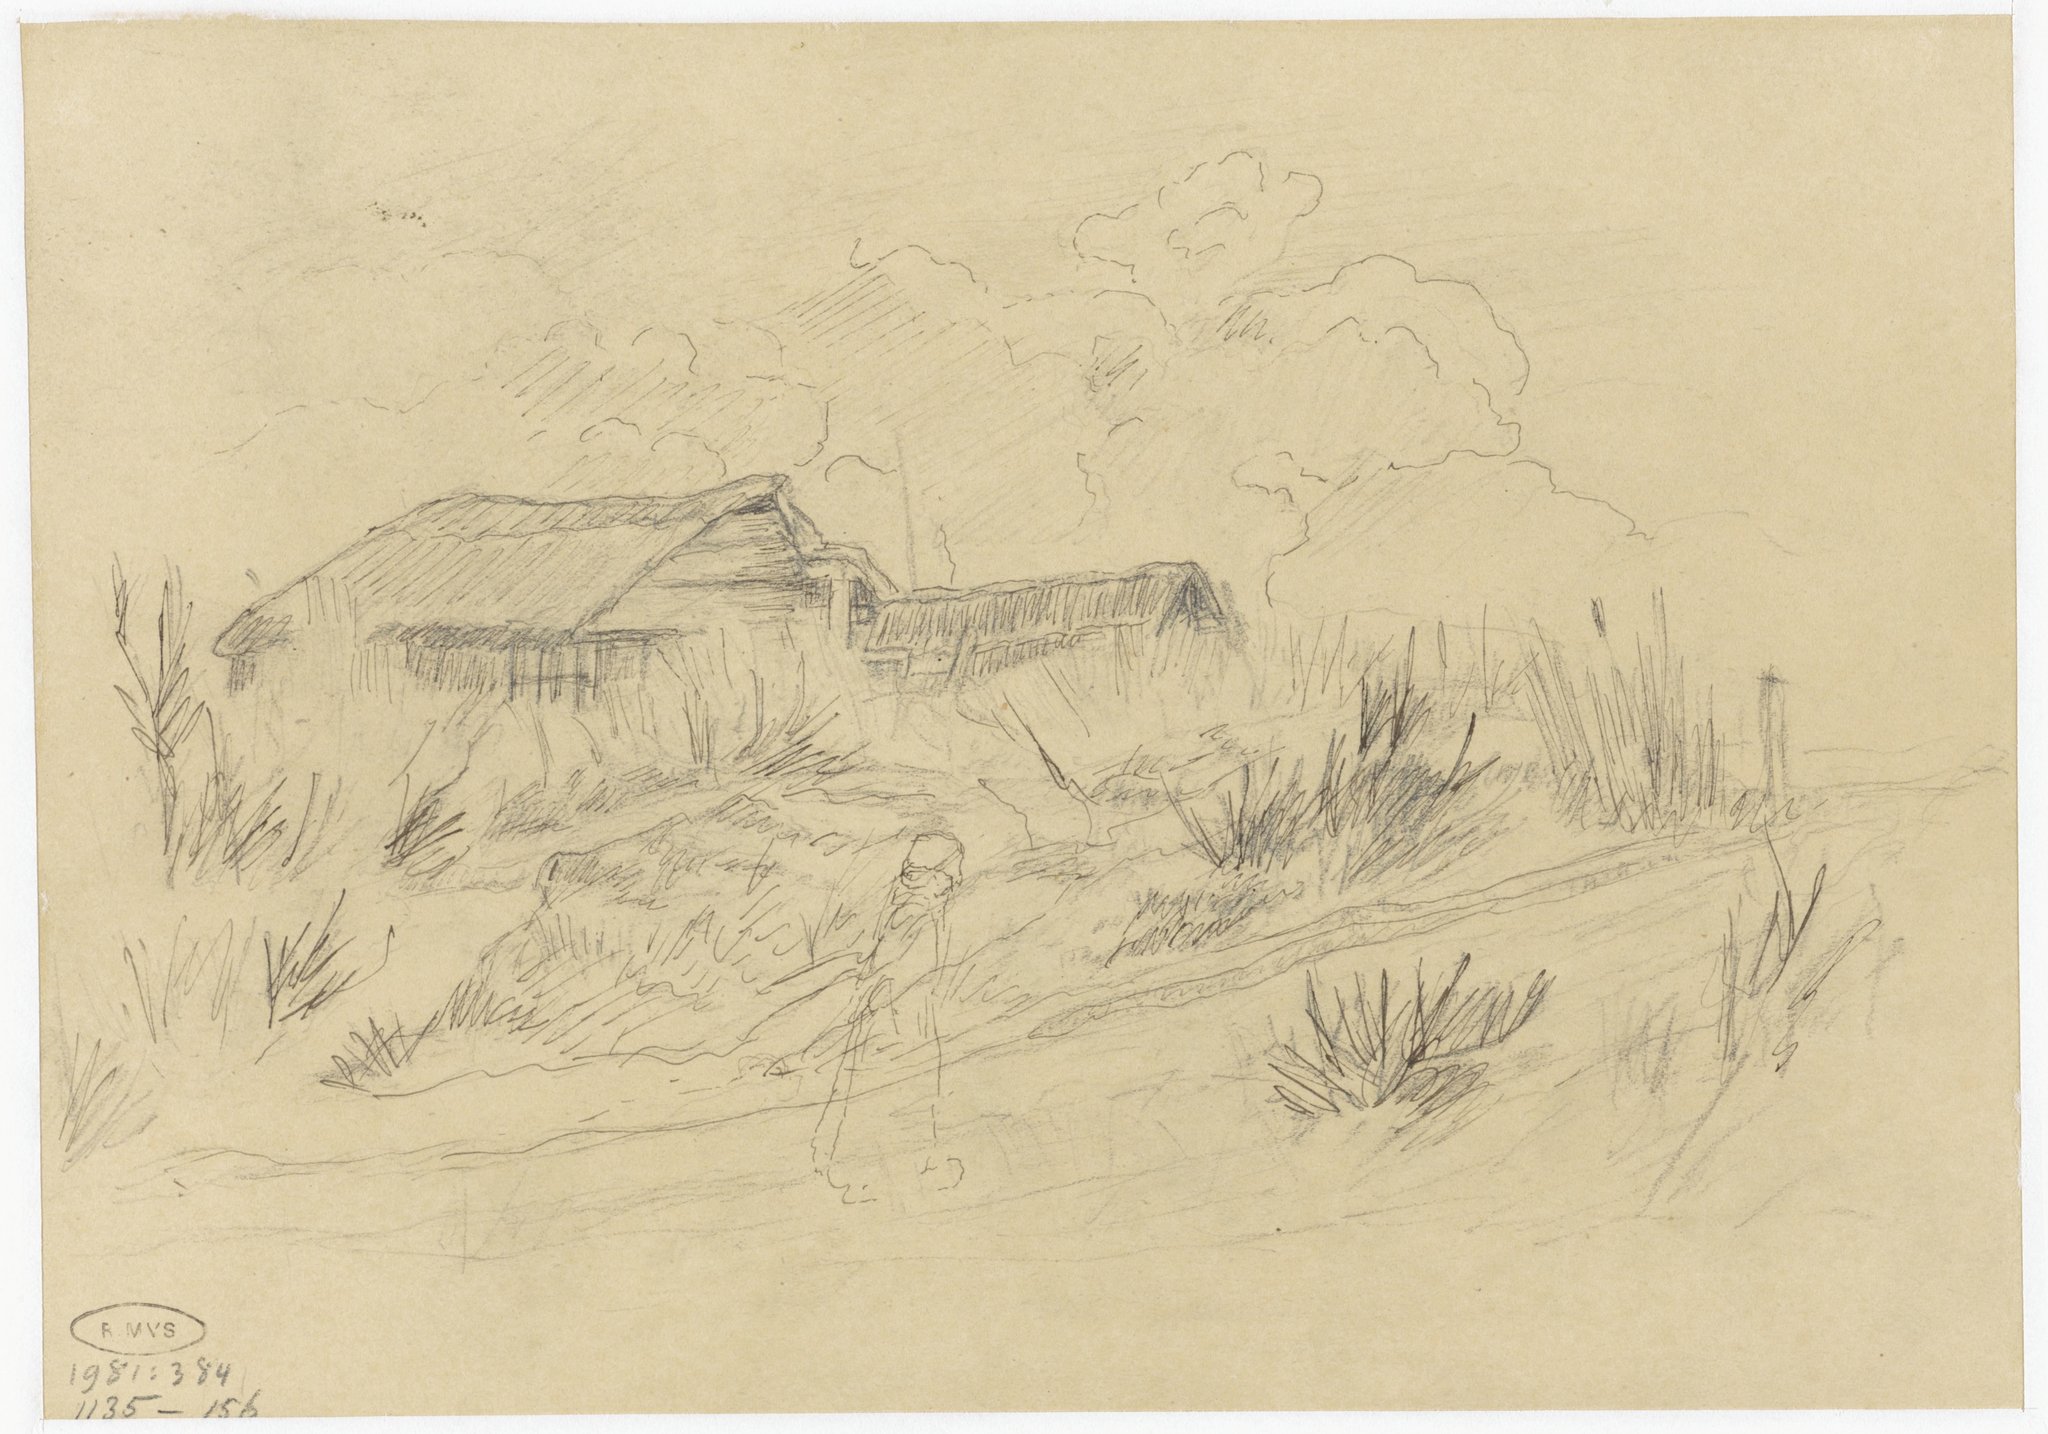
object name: drawing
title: Boerderij bij een landweg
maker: jozef israëls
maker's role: draughtsman, painter, print maker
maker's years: 1824-1911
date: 1834-1911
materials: chalk, ink, paper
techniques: pen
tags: farm or solitary house in landscape